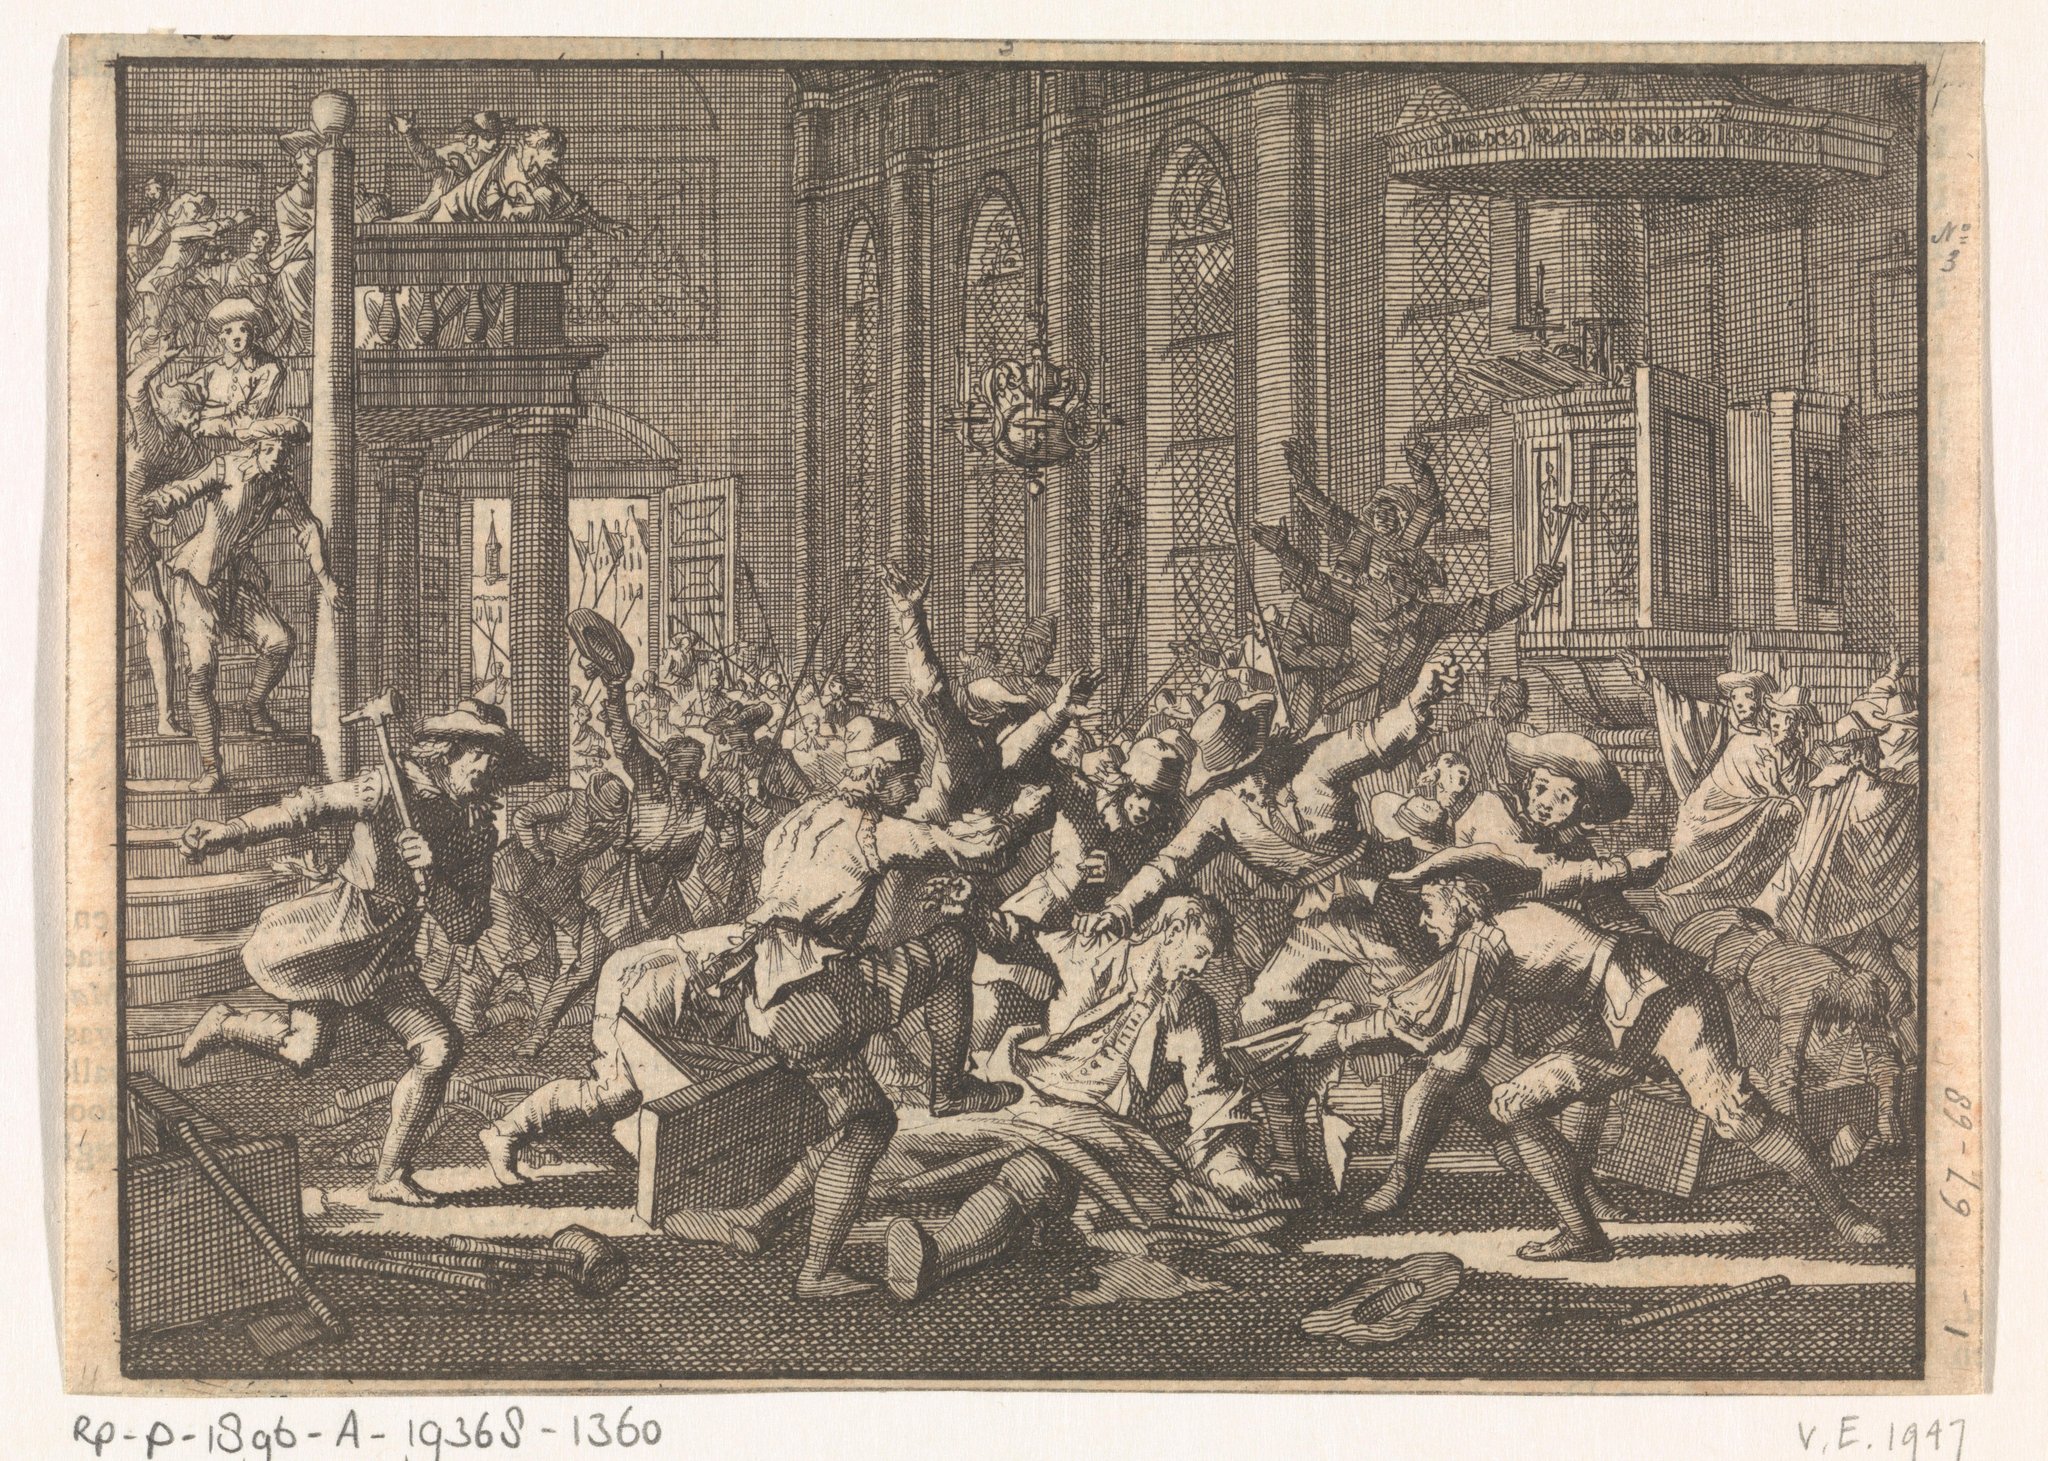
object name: print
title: Oproer in de kerk te Marburg waar ds. Schonerus wordt mishandeld, 1606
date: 1698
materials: paper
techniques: etching, letterpress printing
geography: leiden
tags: interior of church, fighting, violent death, being killed; being mishandled and maltreated; seeking death - ee - death not certain; wounded person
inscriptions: collector's mark: Lugt 2228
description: Illustratie uit: Gottfried, Johann Ludwig. Historische kronyck; vervattende een (...) beschrijvingh der aldergedenckwaerdigste geschiedenissen des weerelds, van den aenvangh der scheppingh tot (...) 1576 (2 delen). Leiden: Pieter van der Aa, 1698, dl. I, p. 67.